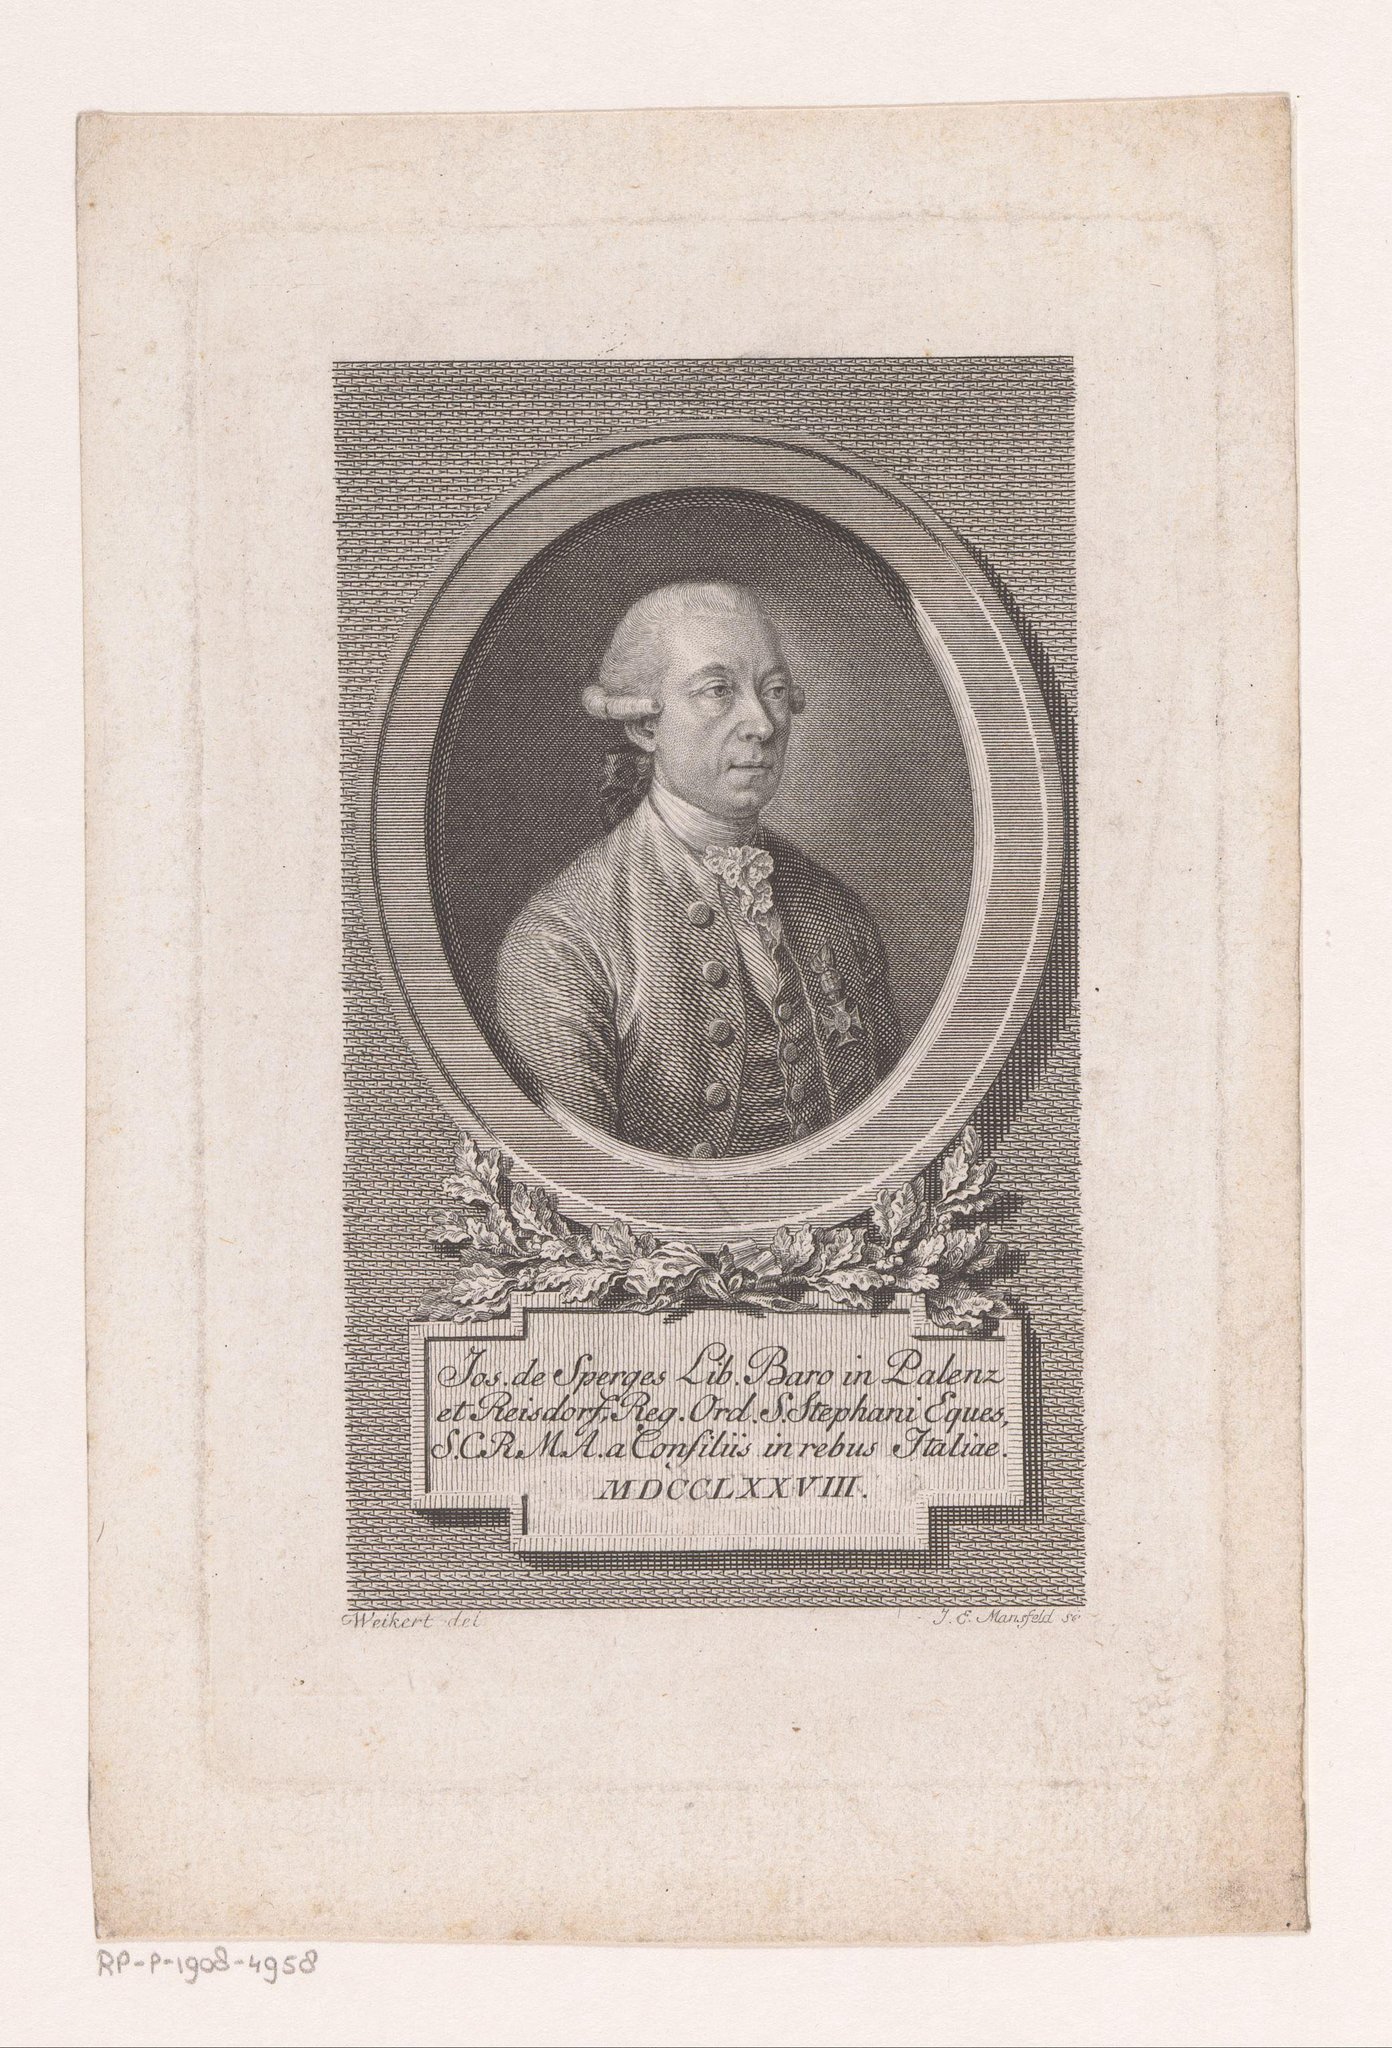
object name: print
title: Portret van Joseph von Sperges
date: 1749-1796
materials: paper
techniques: engraving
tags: historical persons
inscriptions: collector's mark: Lugt 2228